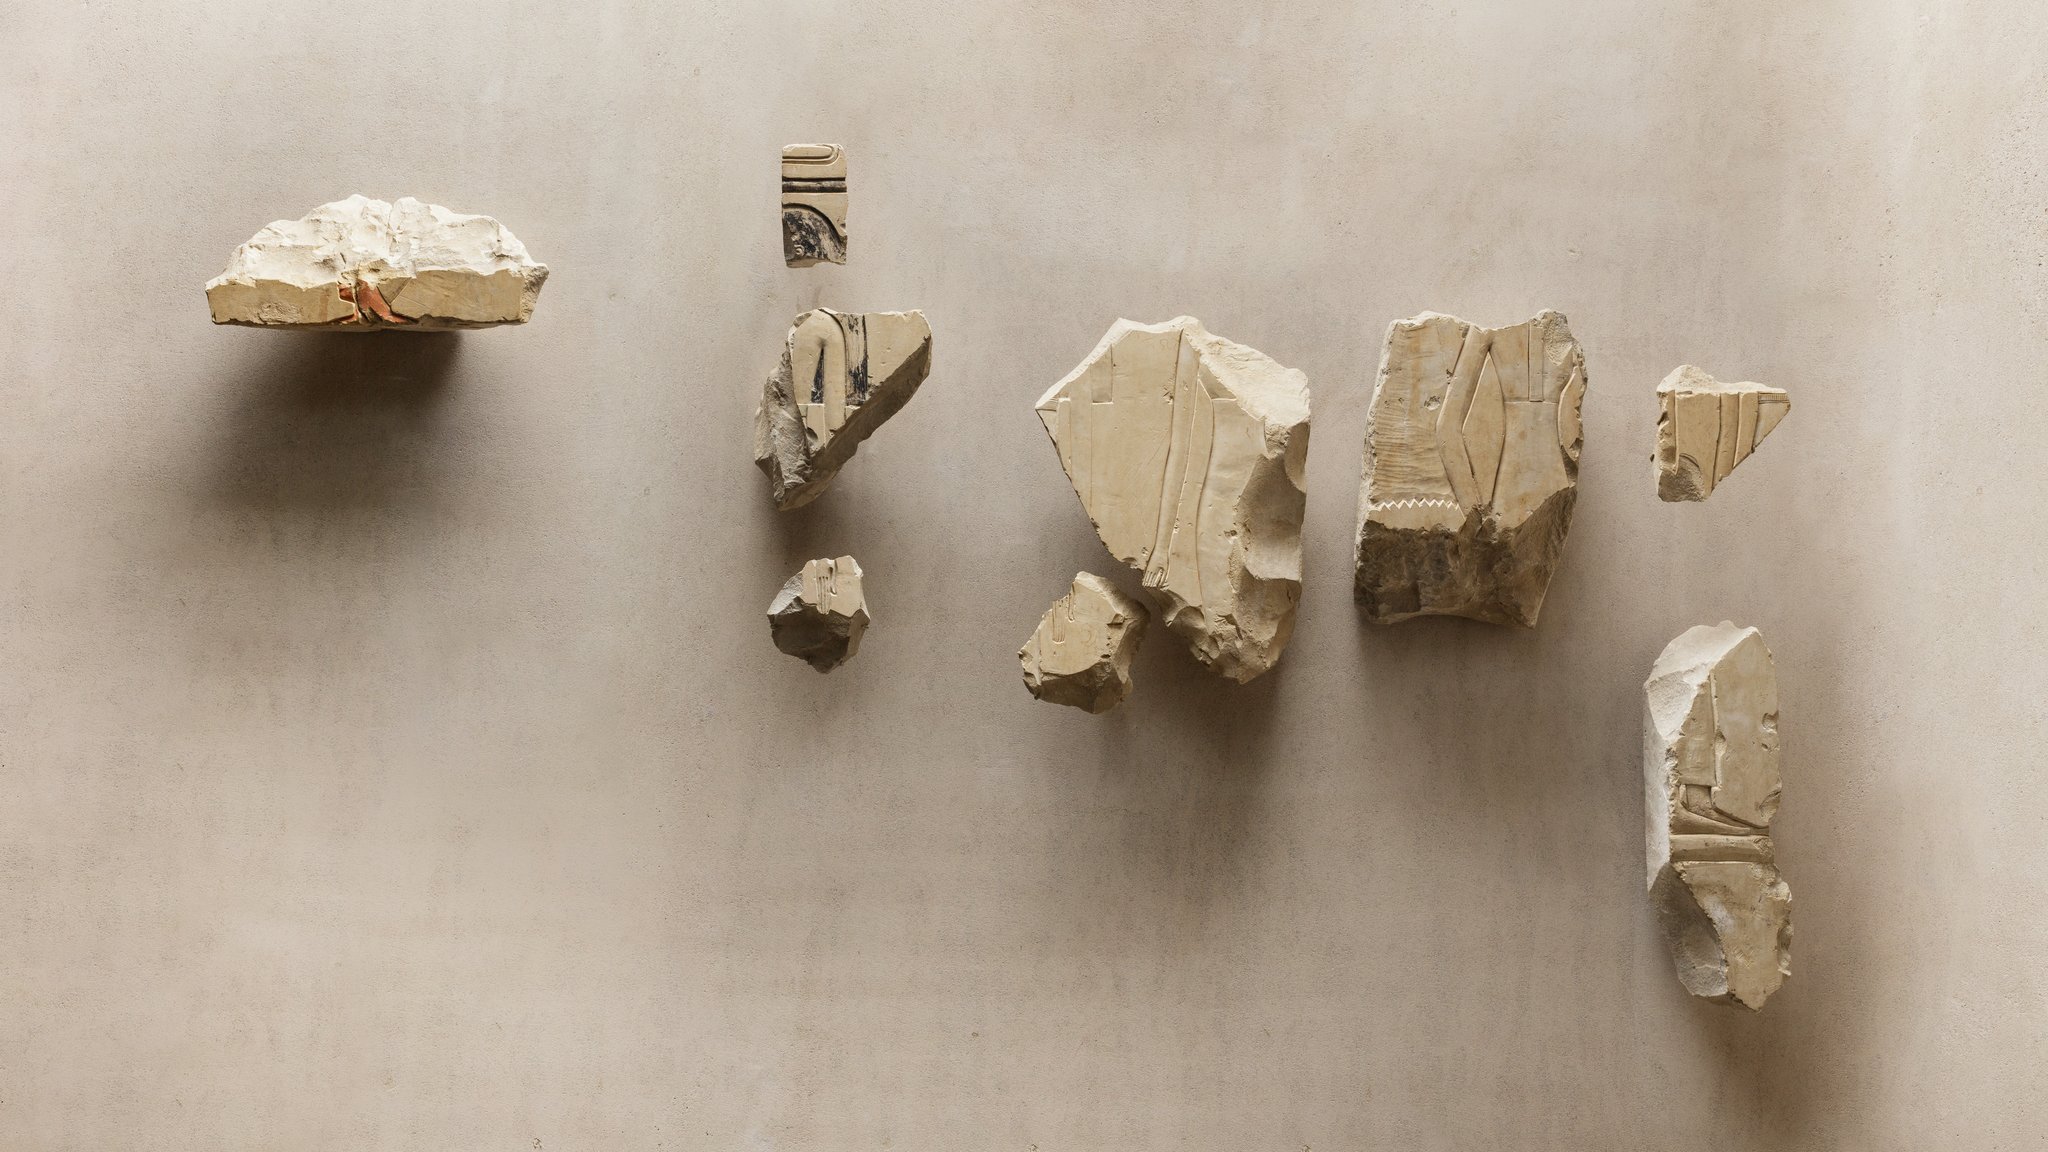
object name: relief fragment, tomb of neferu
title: Relief fragments from procession of attendants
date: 2051-2030 BCE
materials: limestone, paint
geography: egypt